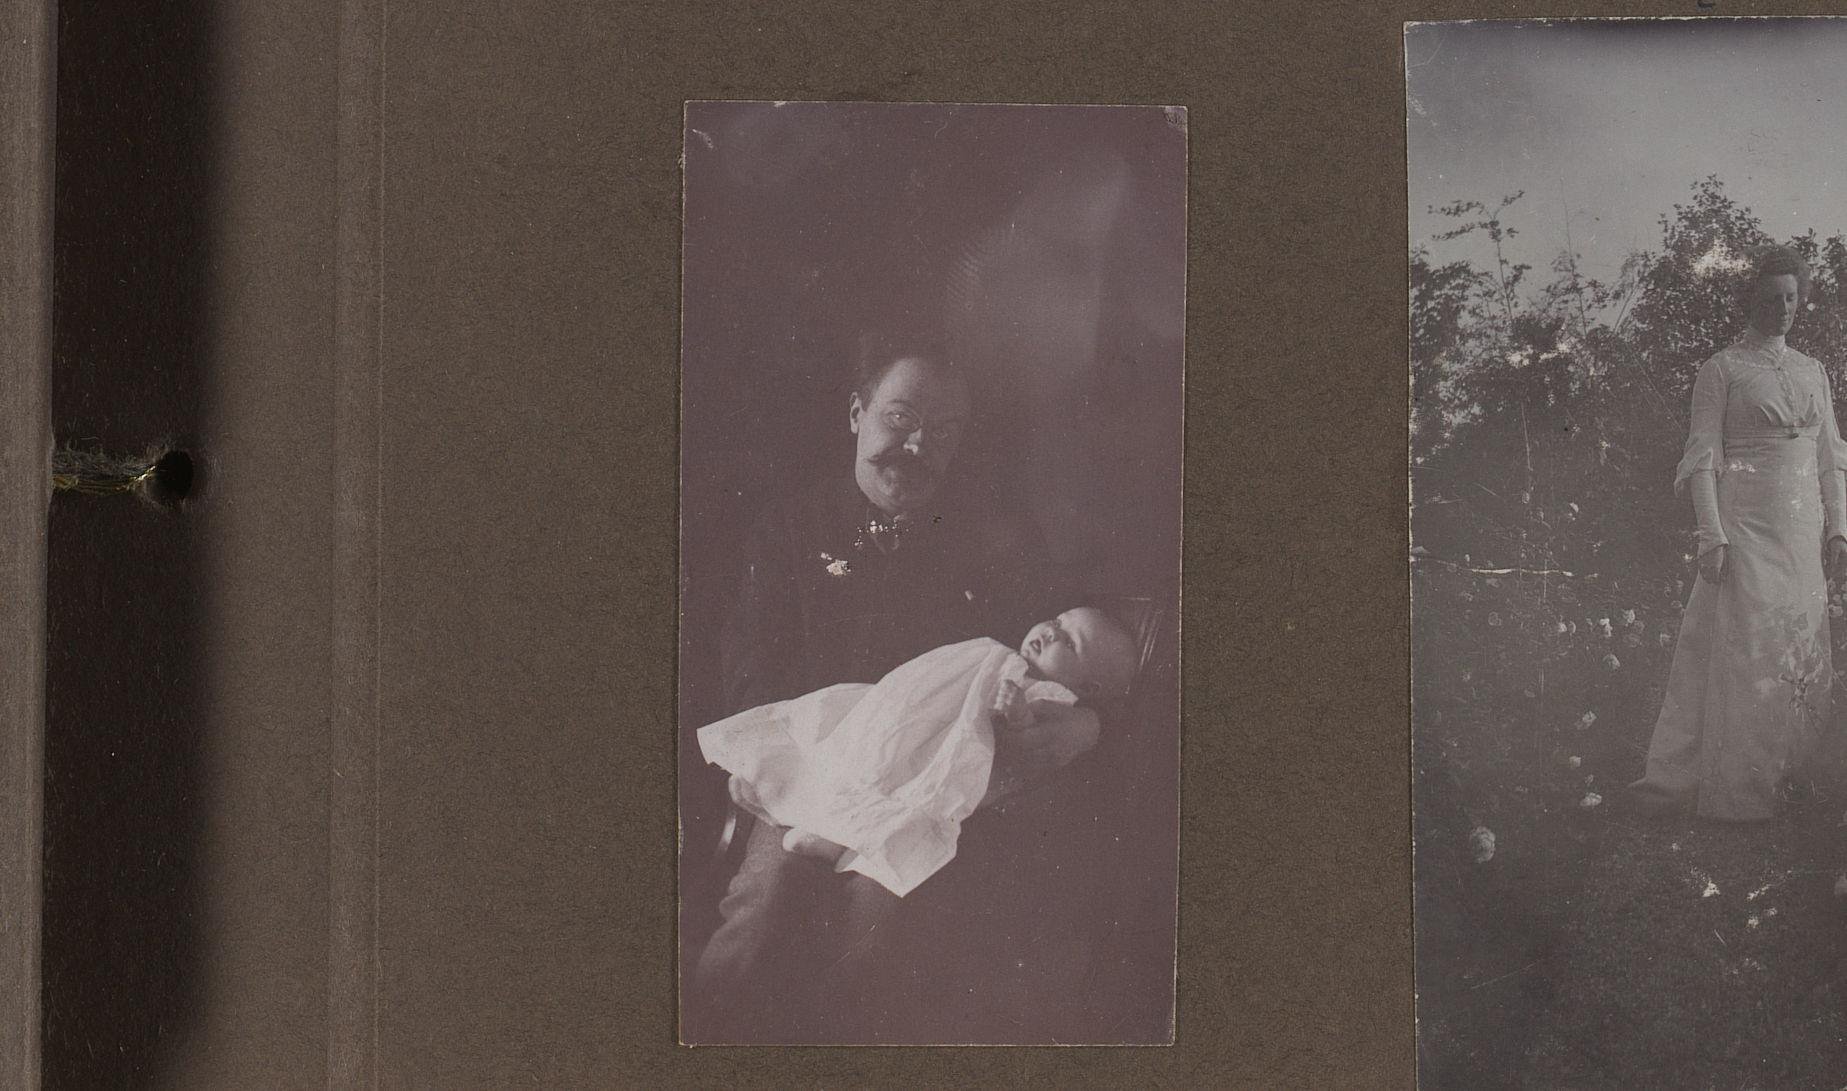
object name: photograph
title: Portret van Alphons Diepenbrock met baby op de arm, vermoedelijk Thea of Joanna Diepenbrock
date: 1905-1910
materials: paper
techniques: collodion silver print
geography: netherlands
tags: amsterdam, alphons diepenbrock, father with daughter(s) (father-love), historical persons, female infant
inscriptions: inscription: ‘"De Hoeve"’